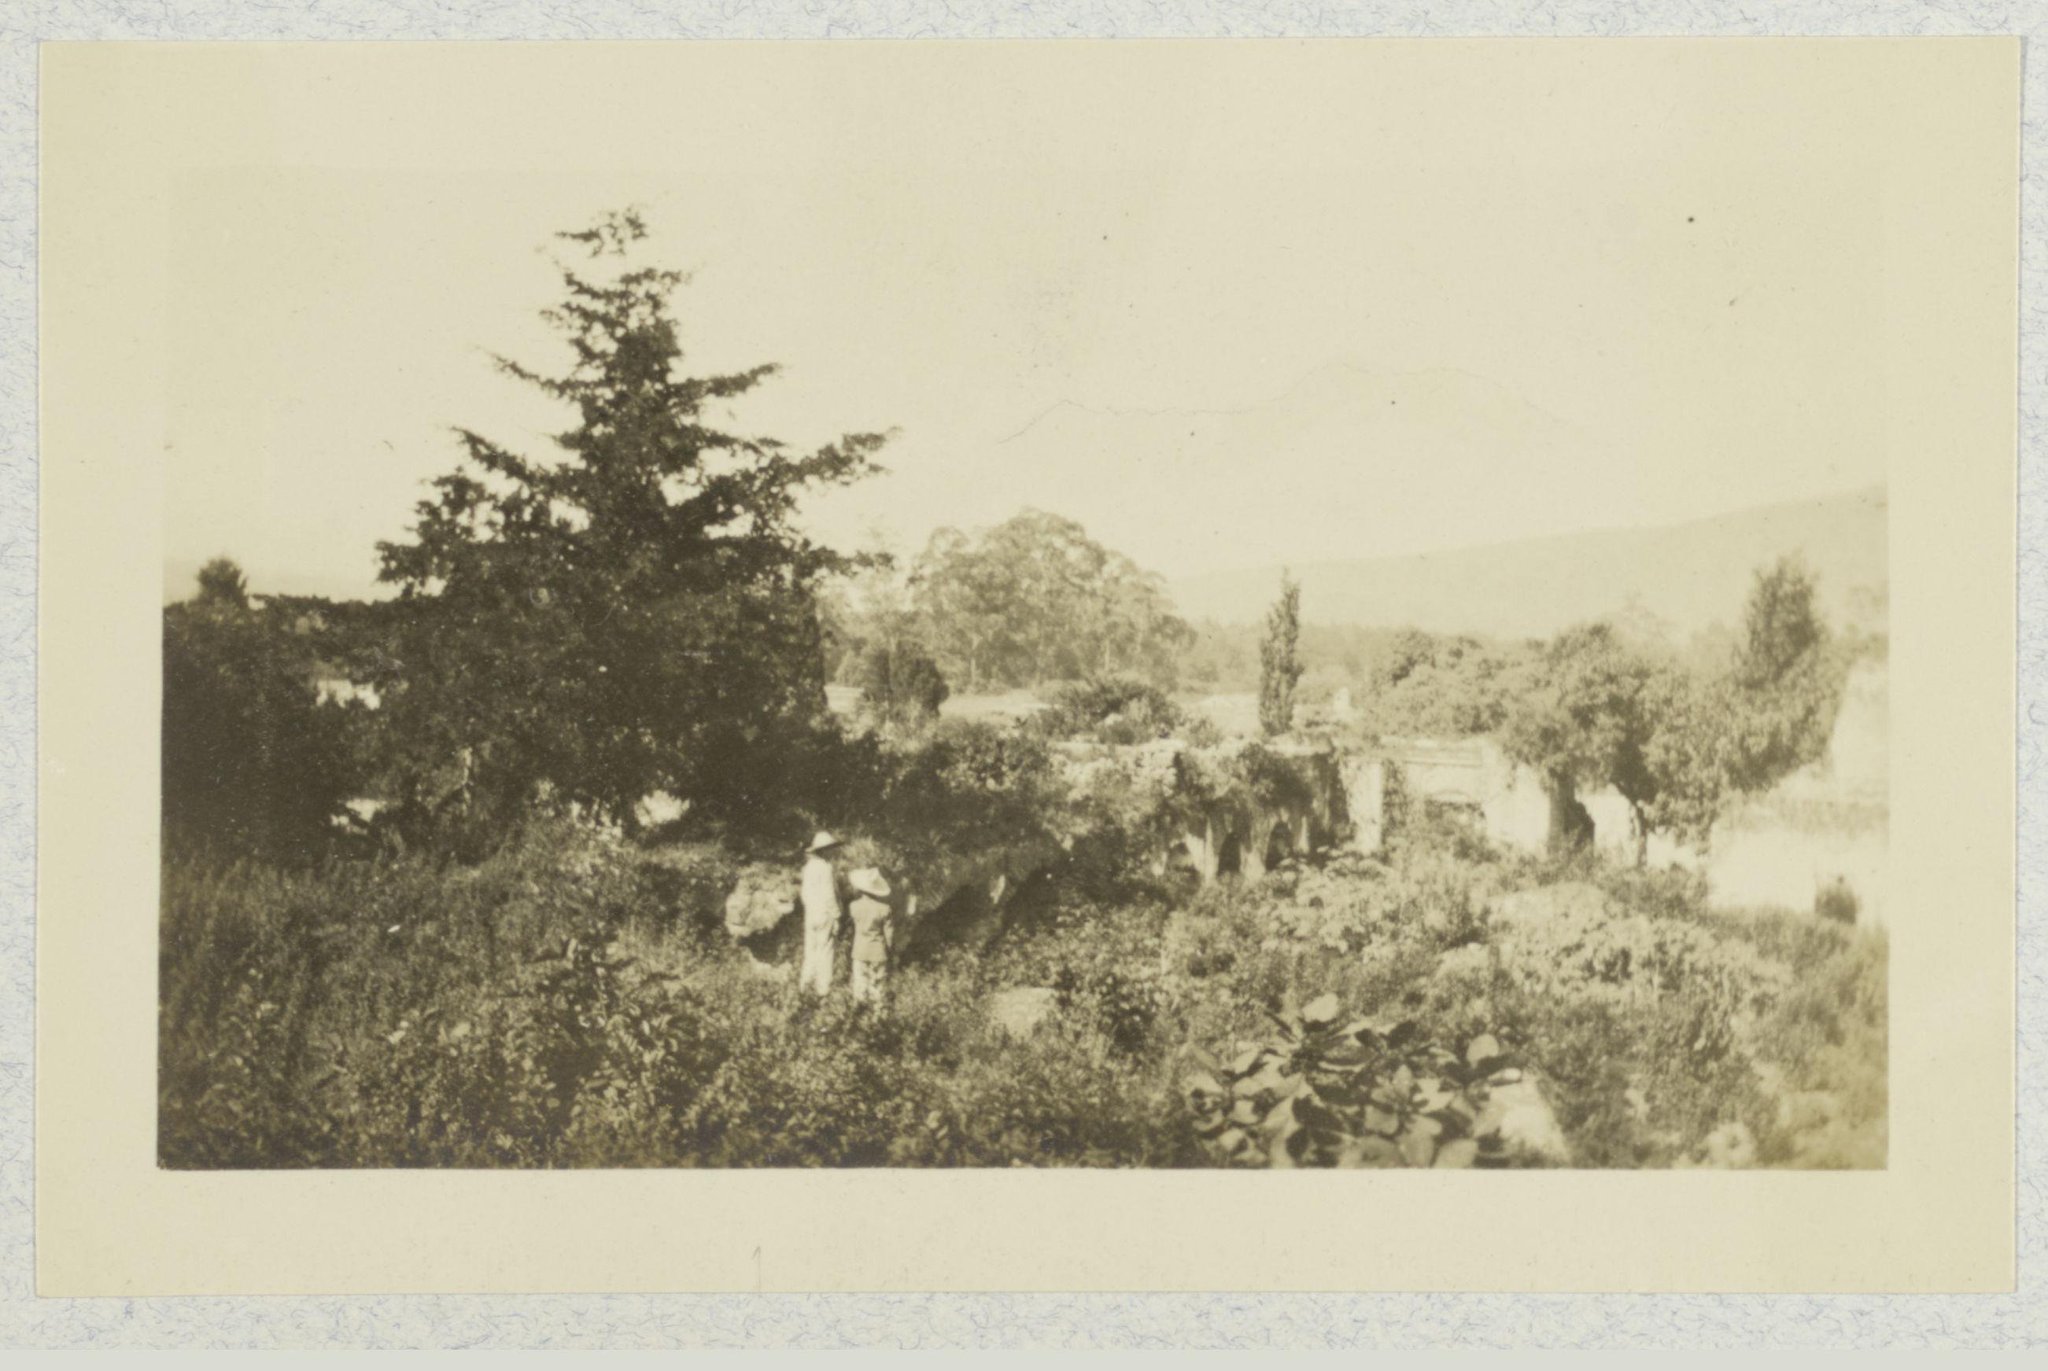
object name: photograph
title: Ruïnes van Antigua Guatemala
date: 1909-1912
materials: photographic support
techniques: photography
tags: landscape with ruins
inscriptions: inscription: ‘Antigua’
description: Ruïnes van Antigua Guatemala, september 1912. Onderdeel van het fotoalbum van de familie Boom-Gonggrijp in Suriname en Curaçao.